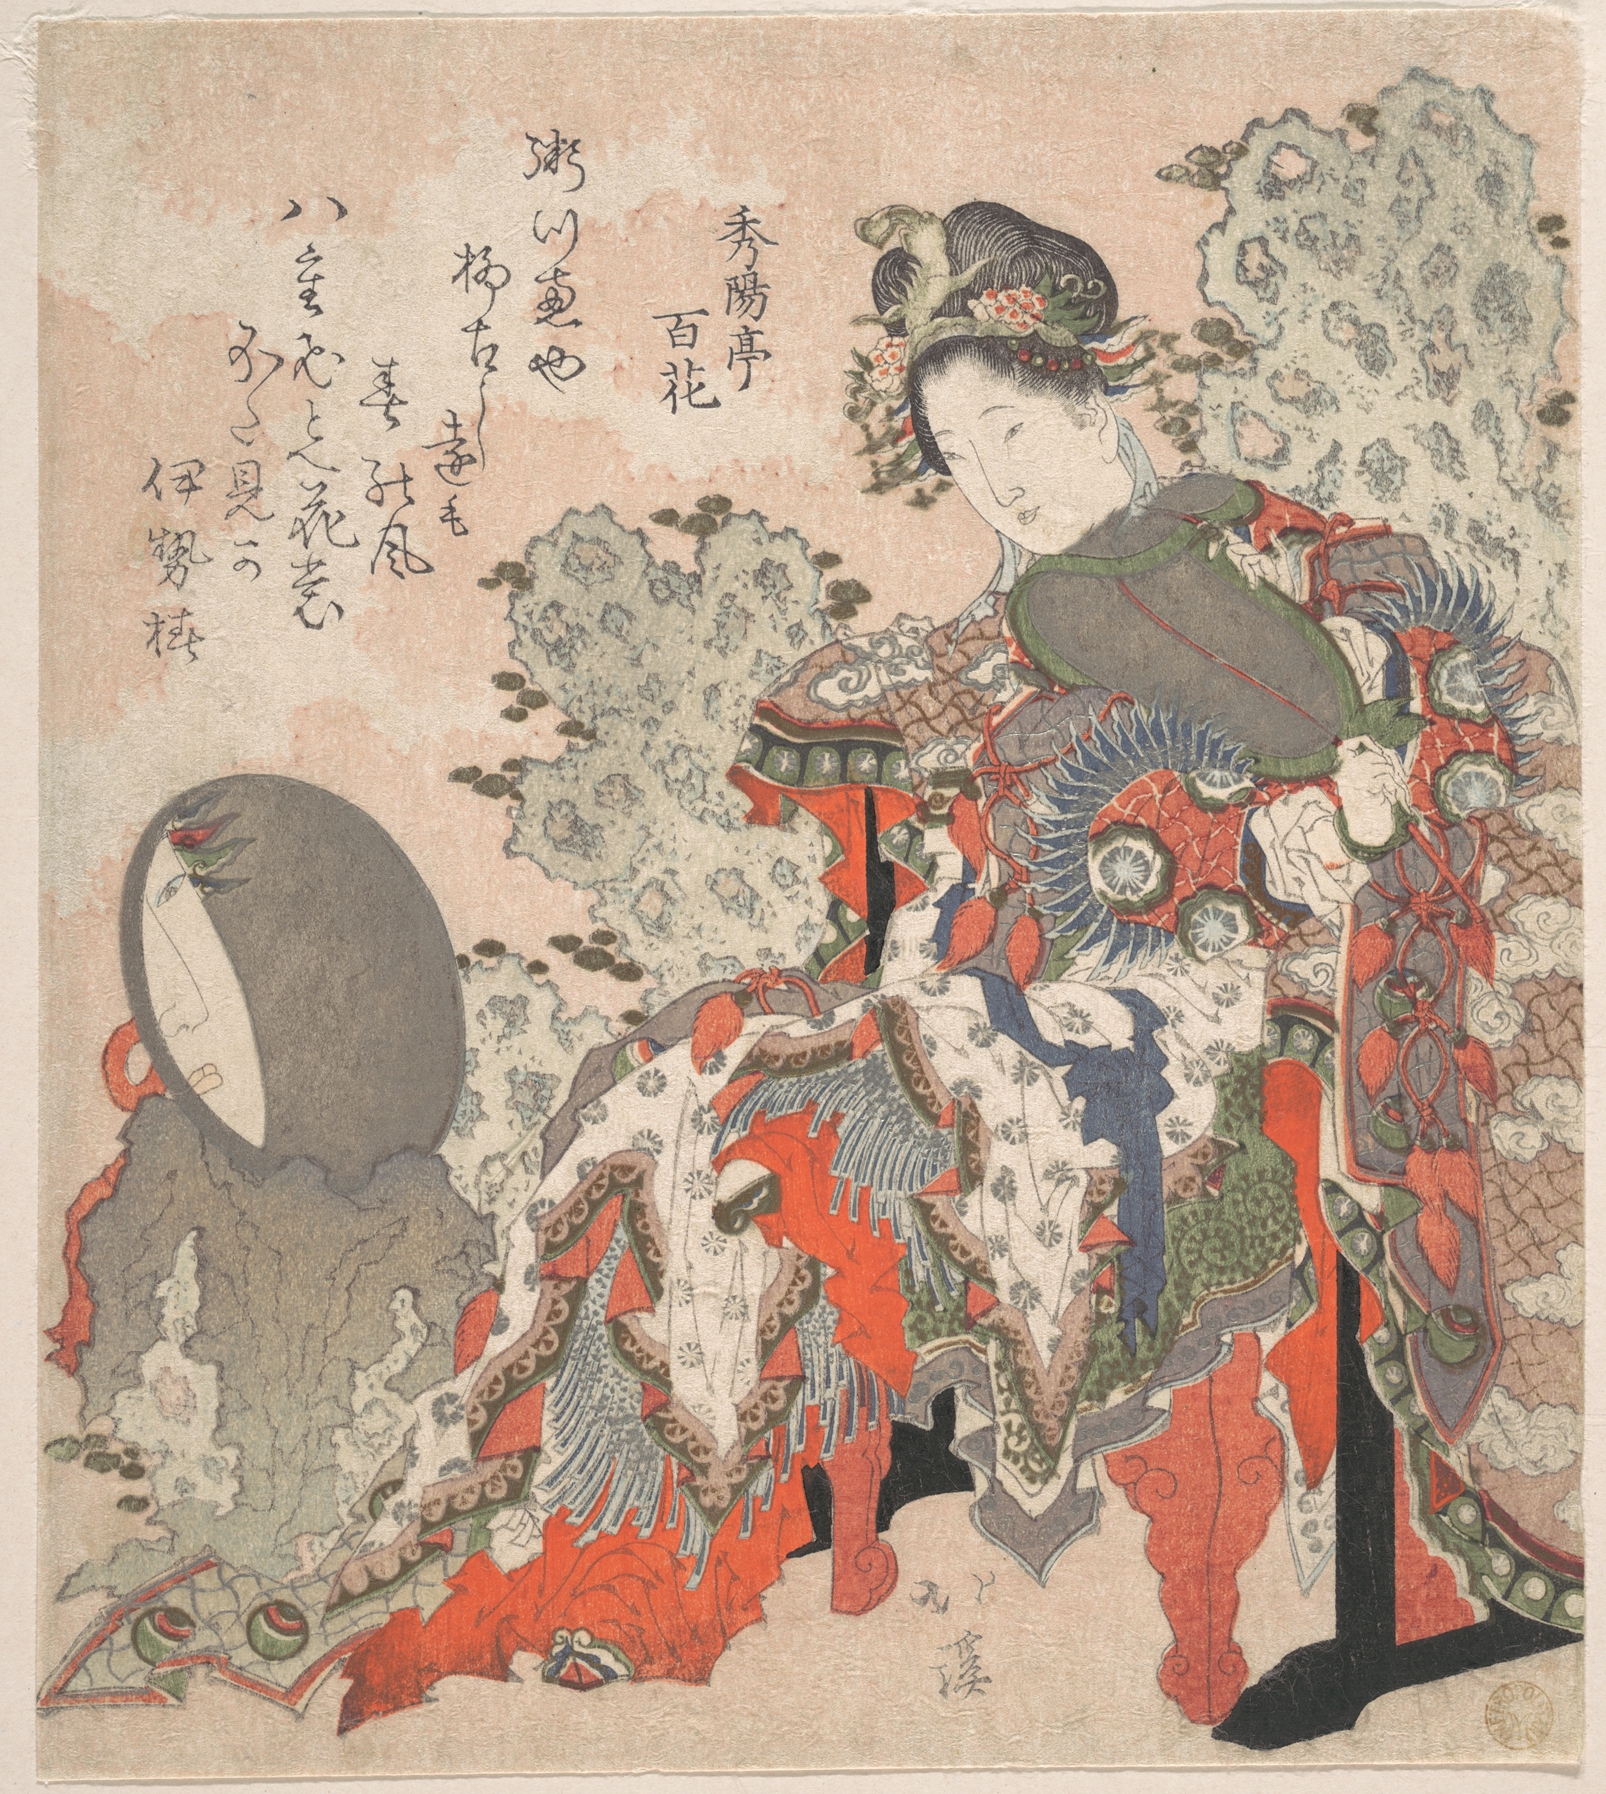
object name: print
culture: japanese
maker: totoya hokkei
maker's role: artist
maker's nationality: japanese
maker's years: 1780-1850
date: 1830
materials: ink, paper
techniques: surimono, woodblock print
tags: women,mirrors